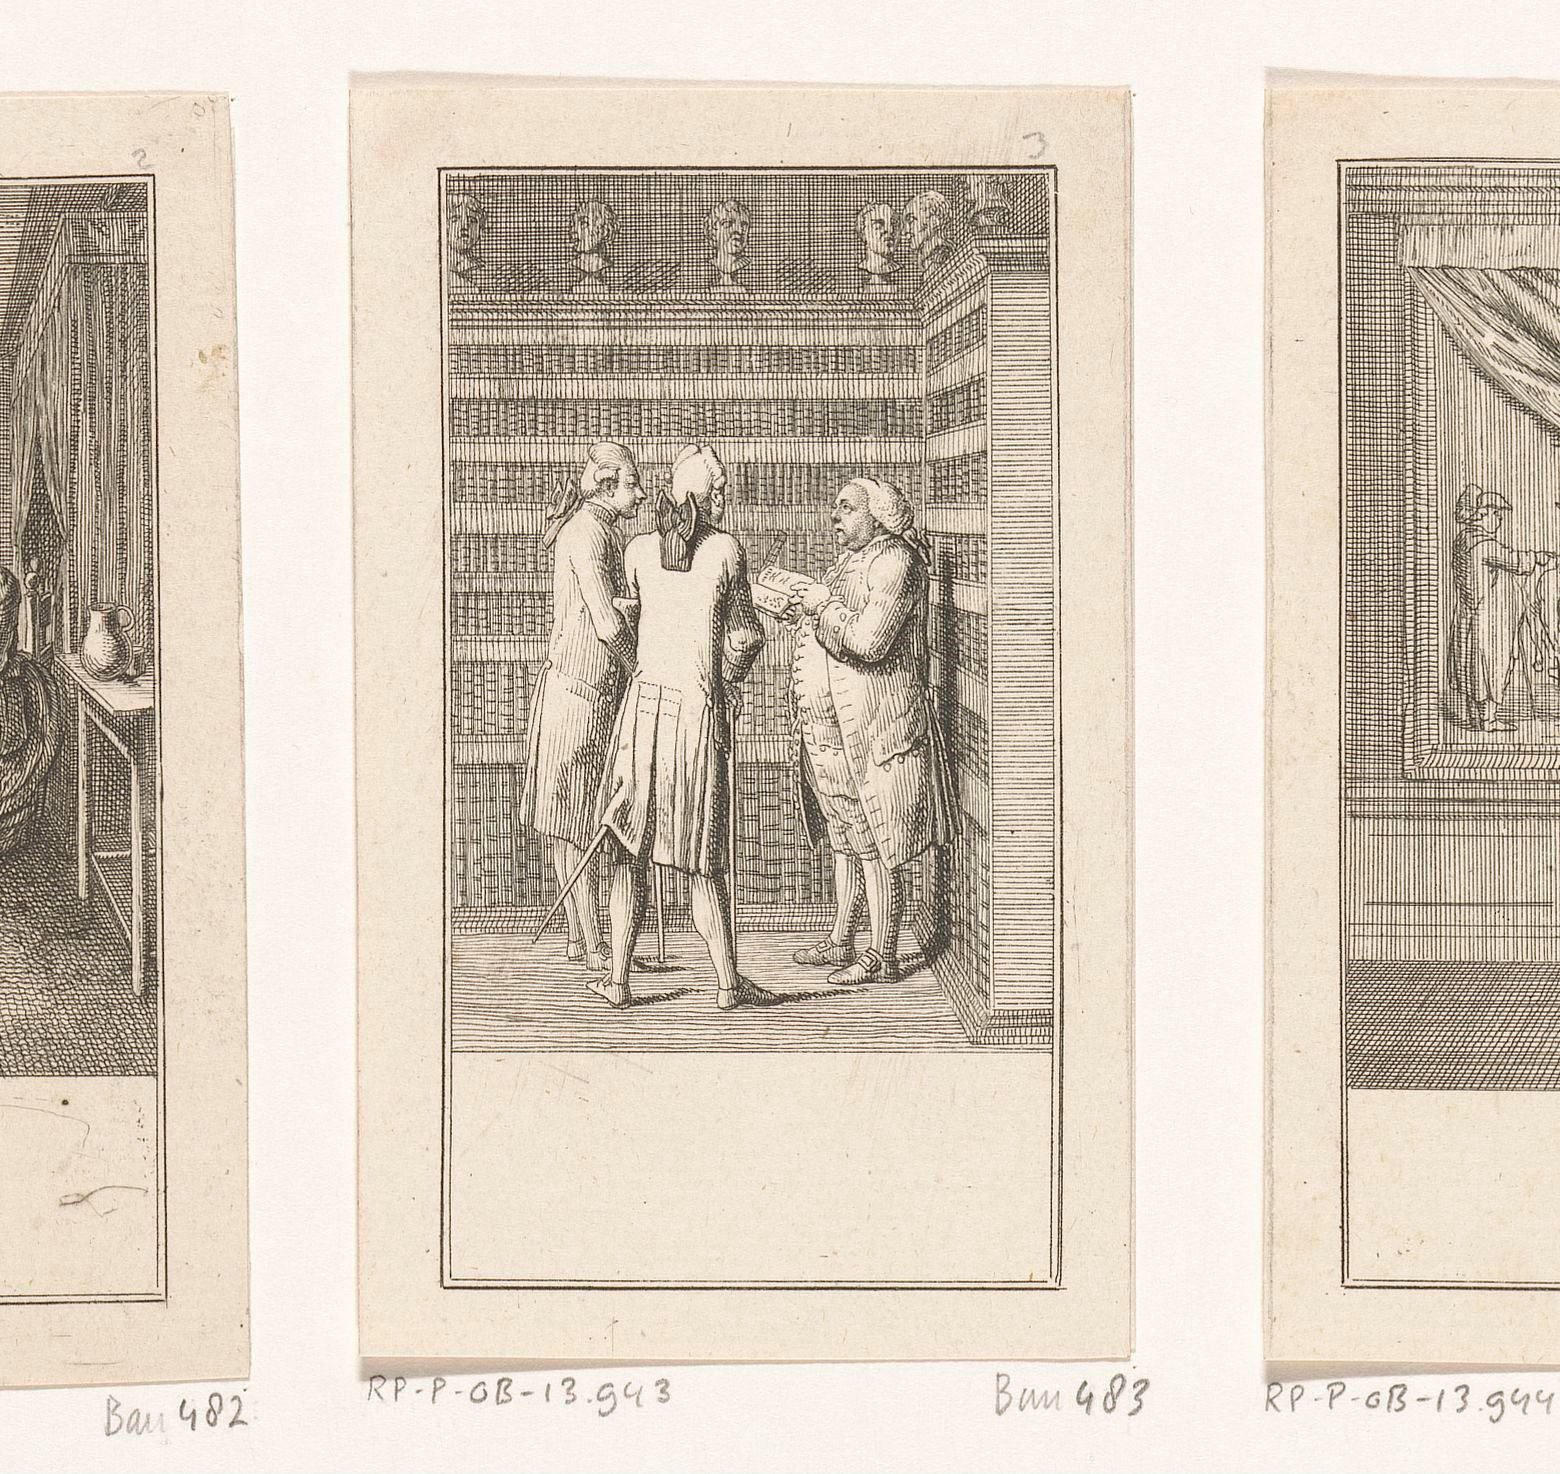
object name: print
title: Drie mannen in een bibliotheek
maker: daniel nikolaus chodowiecki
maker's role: draughtsman, print maker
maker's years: 1726-1801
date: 1778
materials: paper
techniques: etching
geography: berlin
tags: study; 'studiolo'; library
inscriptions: collector's mark: Lugt 2228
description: Derde prent uit een serie van twaalf moralistische en satirische voorstellingen. De scènes werden op een plaat geëtst. Een latere staat van deze serie is gebruikt in: Launburger genealogischen Kalender auf das Jahr 1779. Deze serie is een herhaling van een eerdere serie met onderschriften in het Duits (zie: RP-P-OB-13.938) en het Frans (zie: RP-P-OB-13.393 en RP-P-OB-13.940).